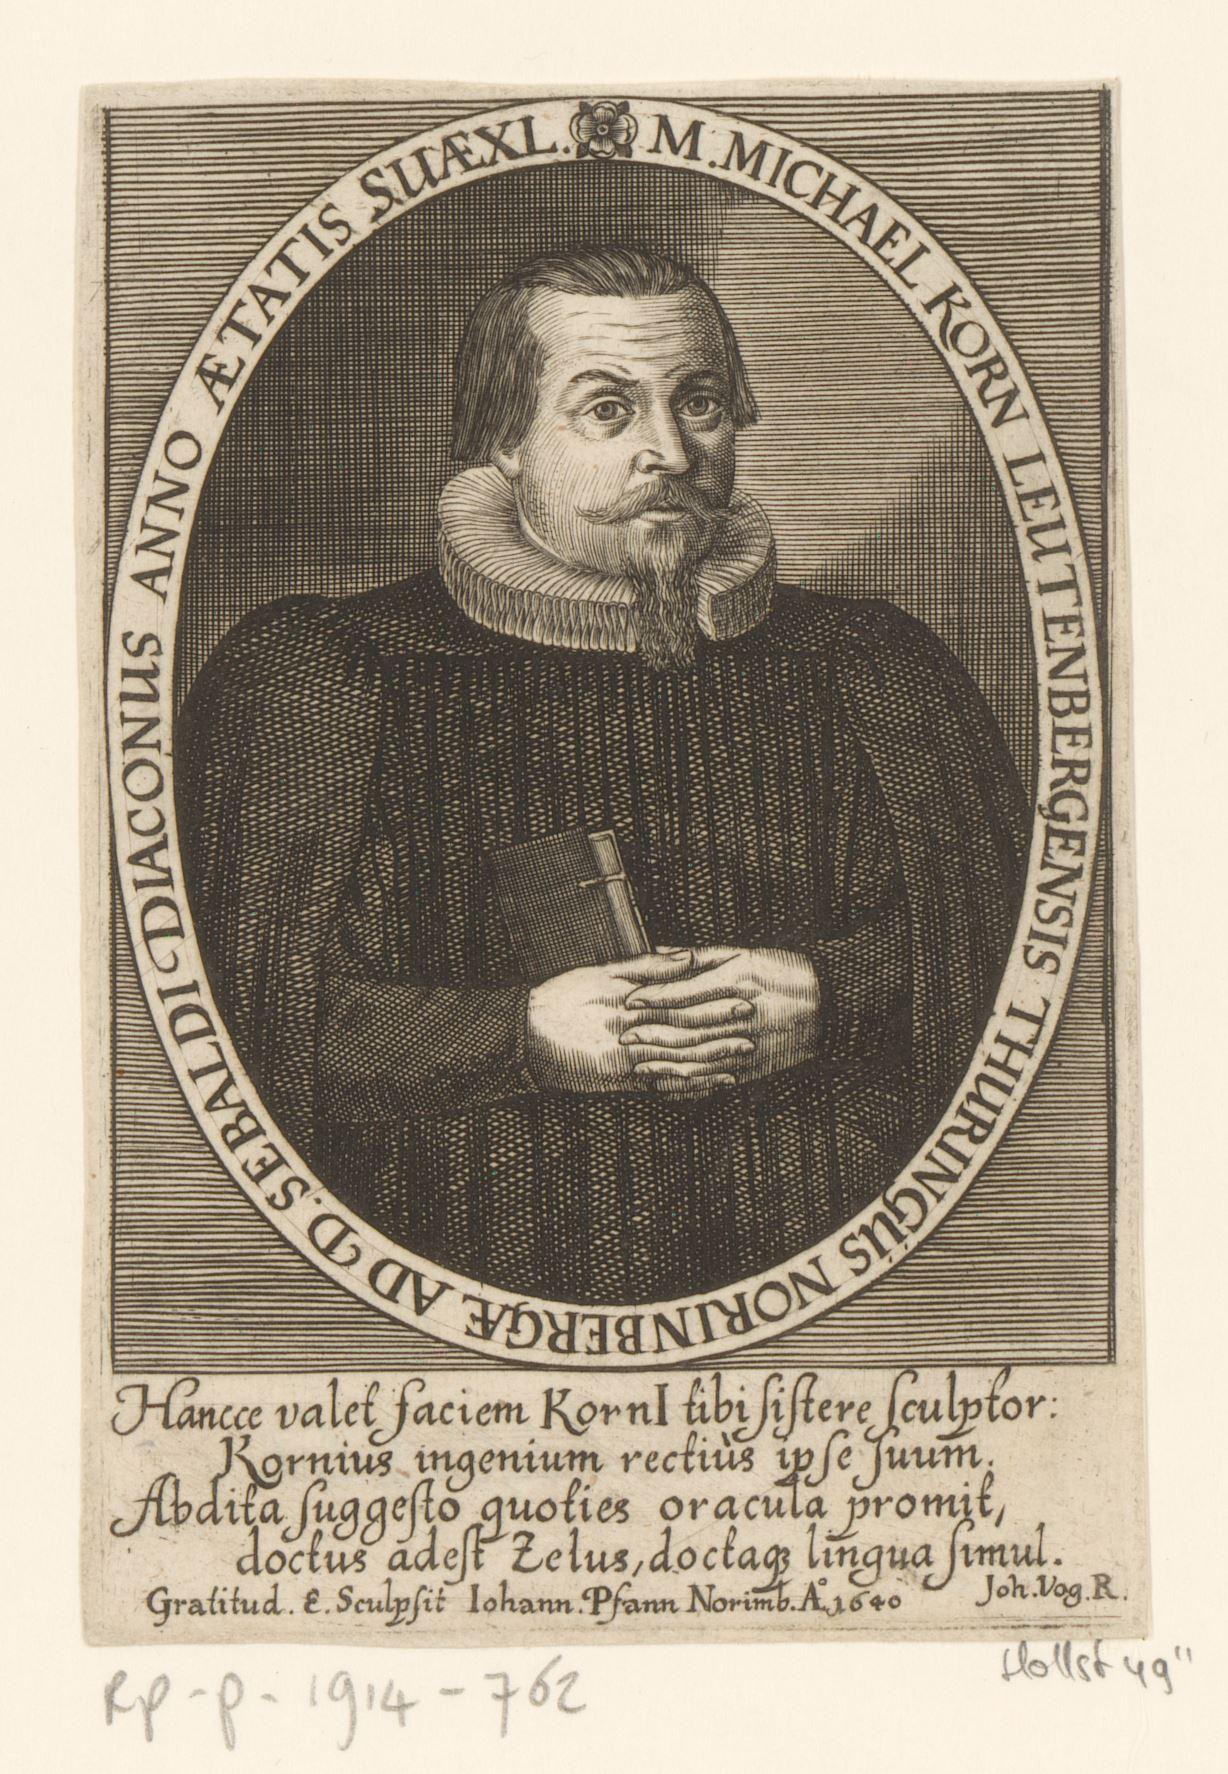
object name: print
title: Portret van Michael Korn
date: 1648-1663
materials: paper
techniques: engraving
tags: historical persons, book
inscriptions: collector's mark: Lugt 2228